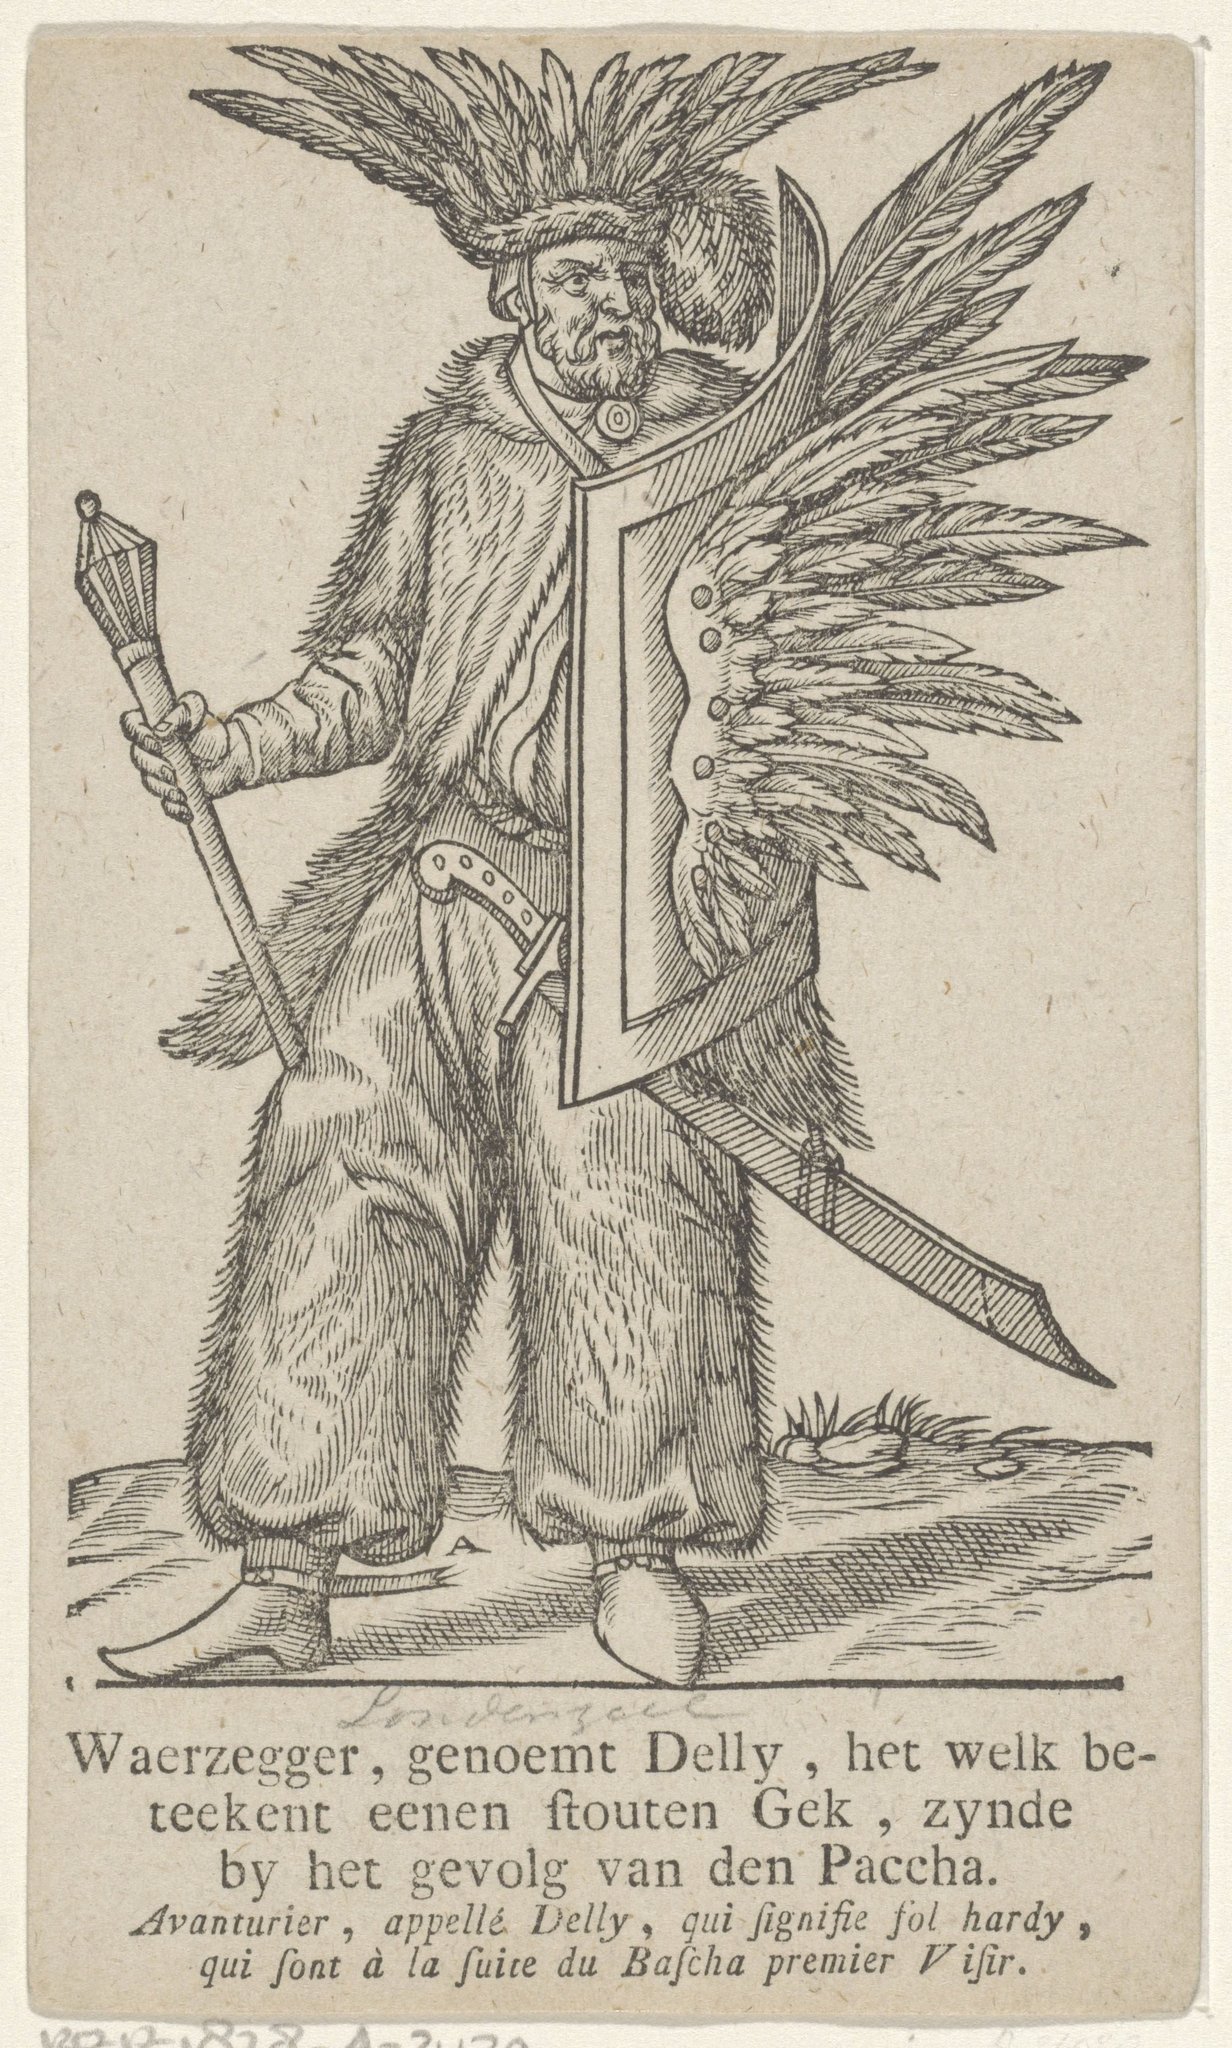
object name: print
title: Waerzegger, genoemt Delly, het welk beteekent eenen stouten Gek, zynde by het gevolg van den Paccha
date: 1576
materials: paper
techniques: letterpress printing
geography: antwerp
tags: protective weapons: shield, asiatic races and peoples: turks, hacking and thrusting weapons (with name), weapons for striking a blow: club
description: Man uit Paccha met een knots, een sabel en een schild. Zijn hoofd en zijn schild zijn met veren versierd. In de ondermarge drie regels Nederlandse en twee regels Franse tekst.